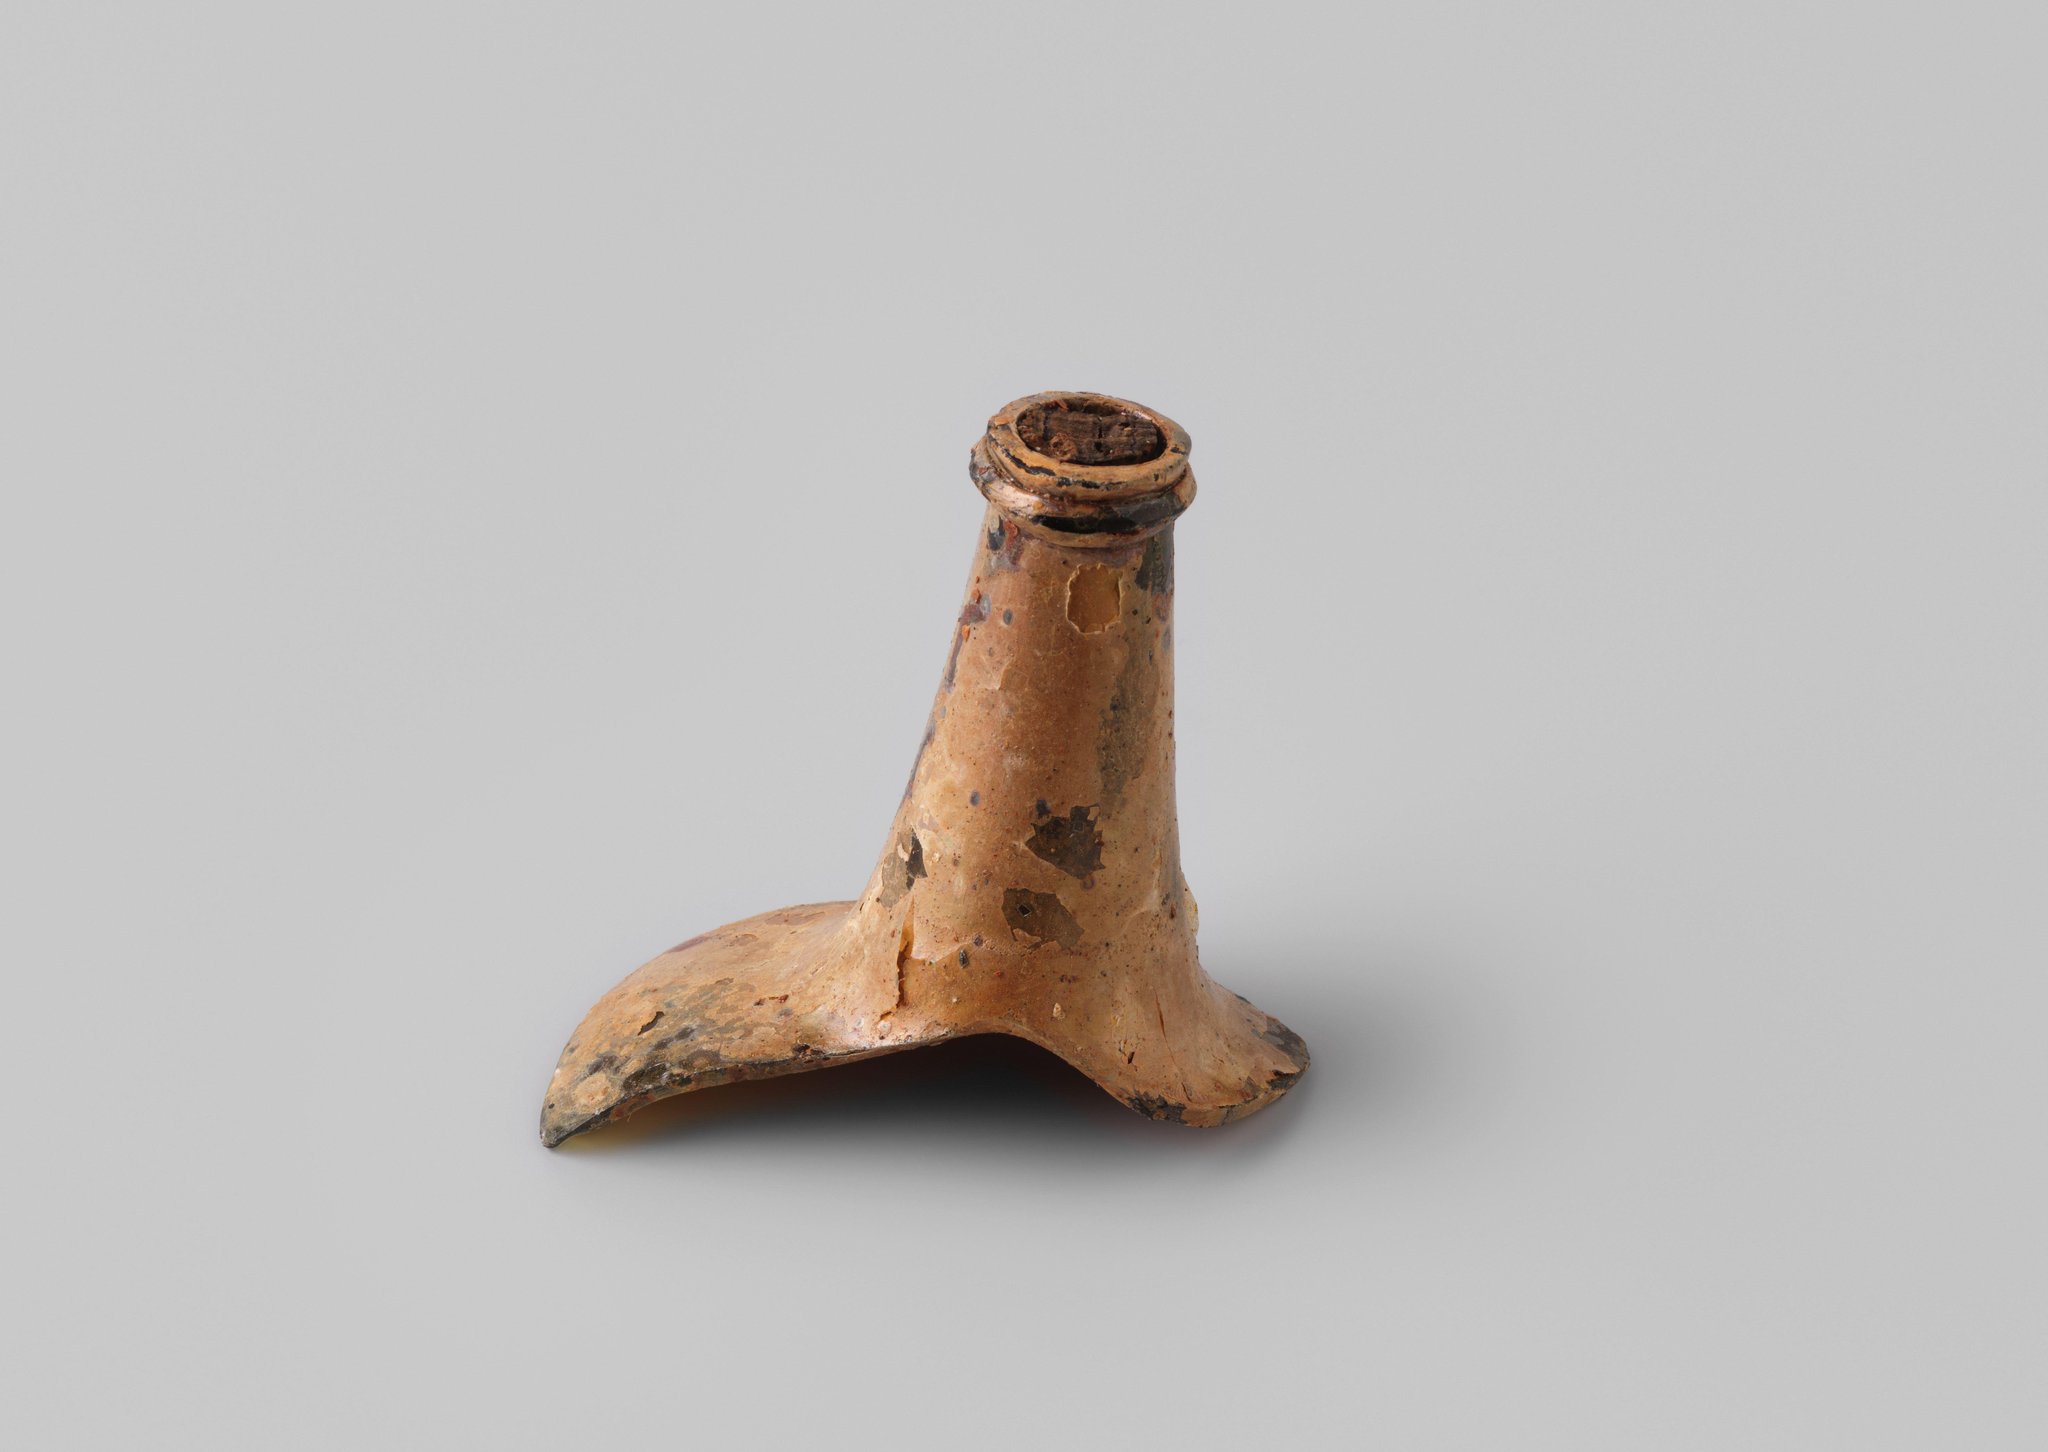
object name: neck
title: Hals met kurk van een wijnfles uit het wrak van de Oost-Indiëvaarder Hollandia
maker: Anonymous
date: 1700-1743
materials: cork, glass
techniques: green glass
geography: netherlands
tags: verenigde oostindische compagnie, hollandia (schip), annet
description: Wine bottle, continental production, neck, onion-shaped bottle or bottle with vertical side; eroded, vs-string rim.